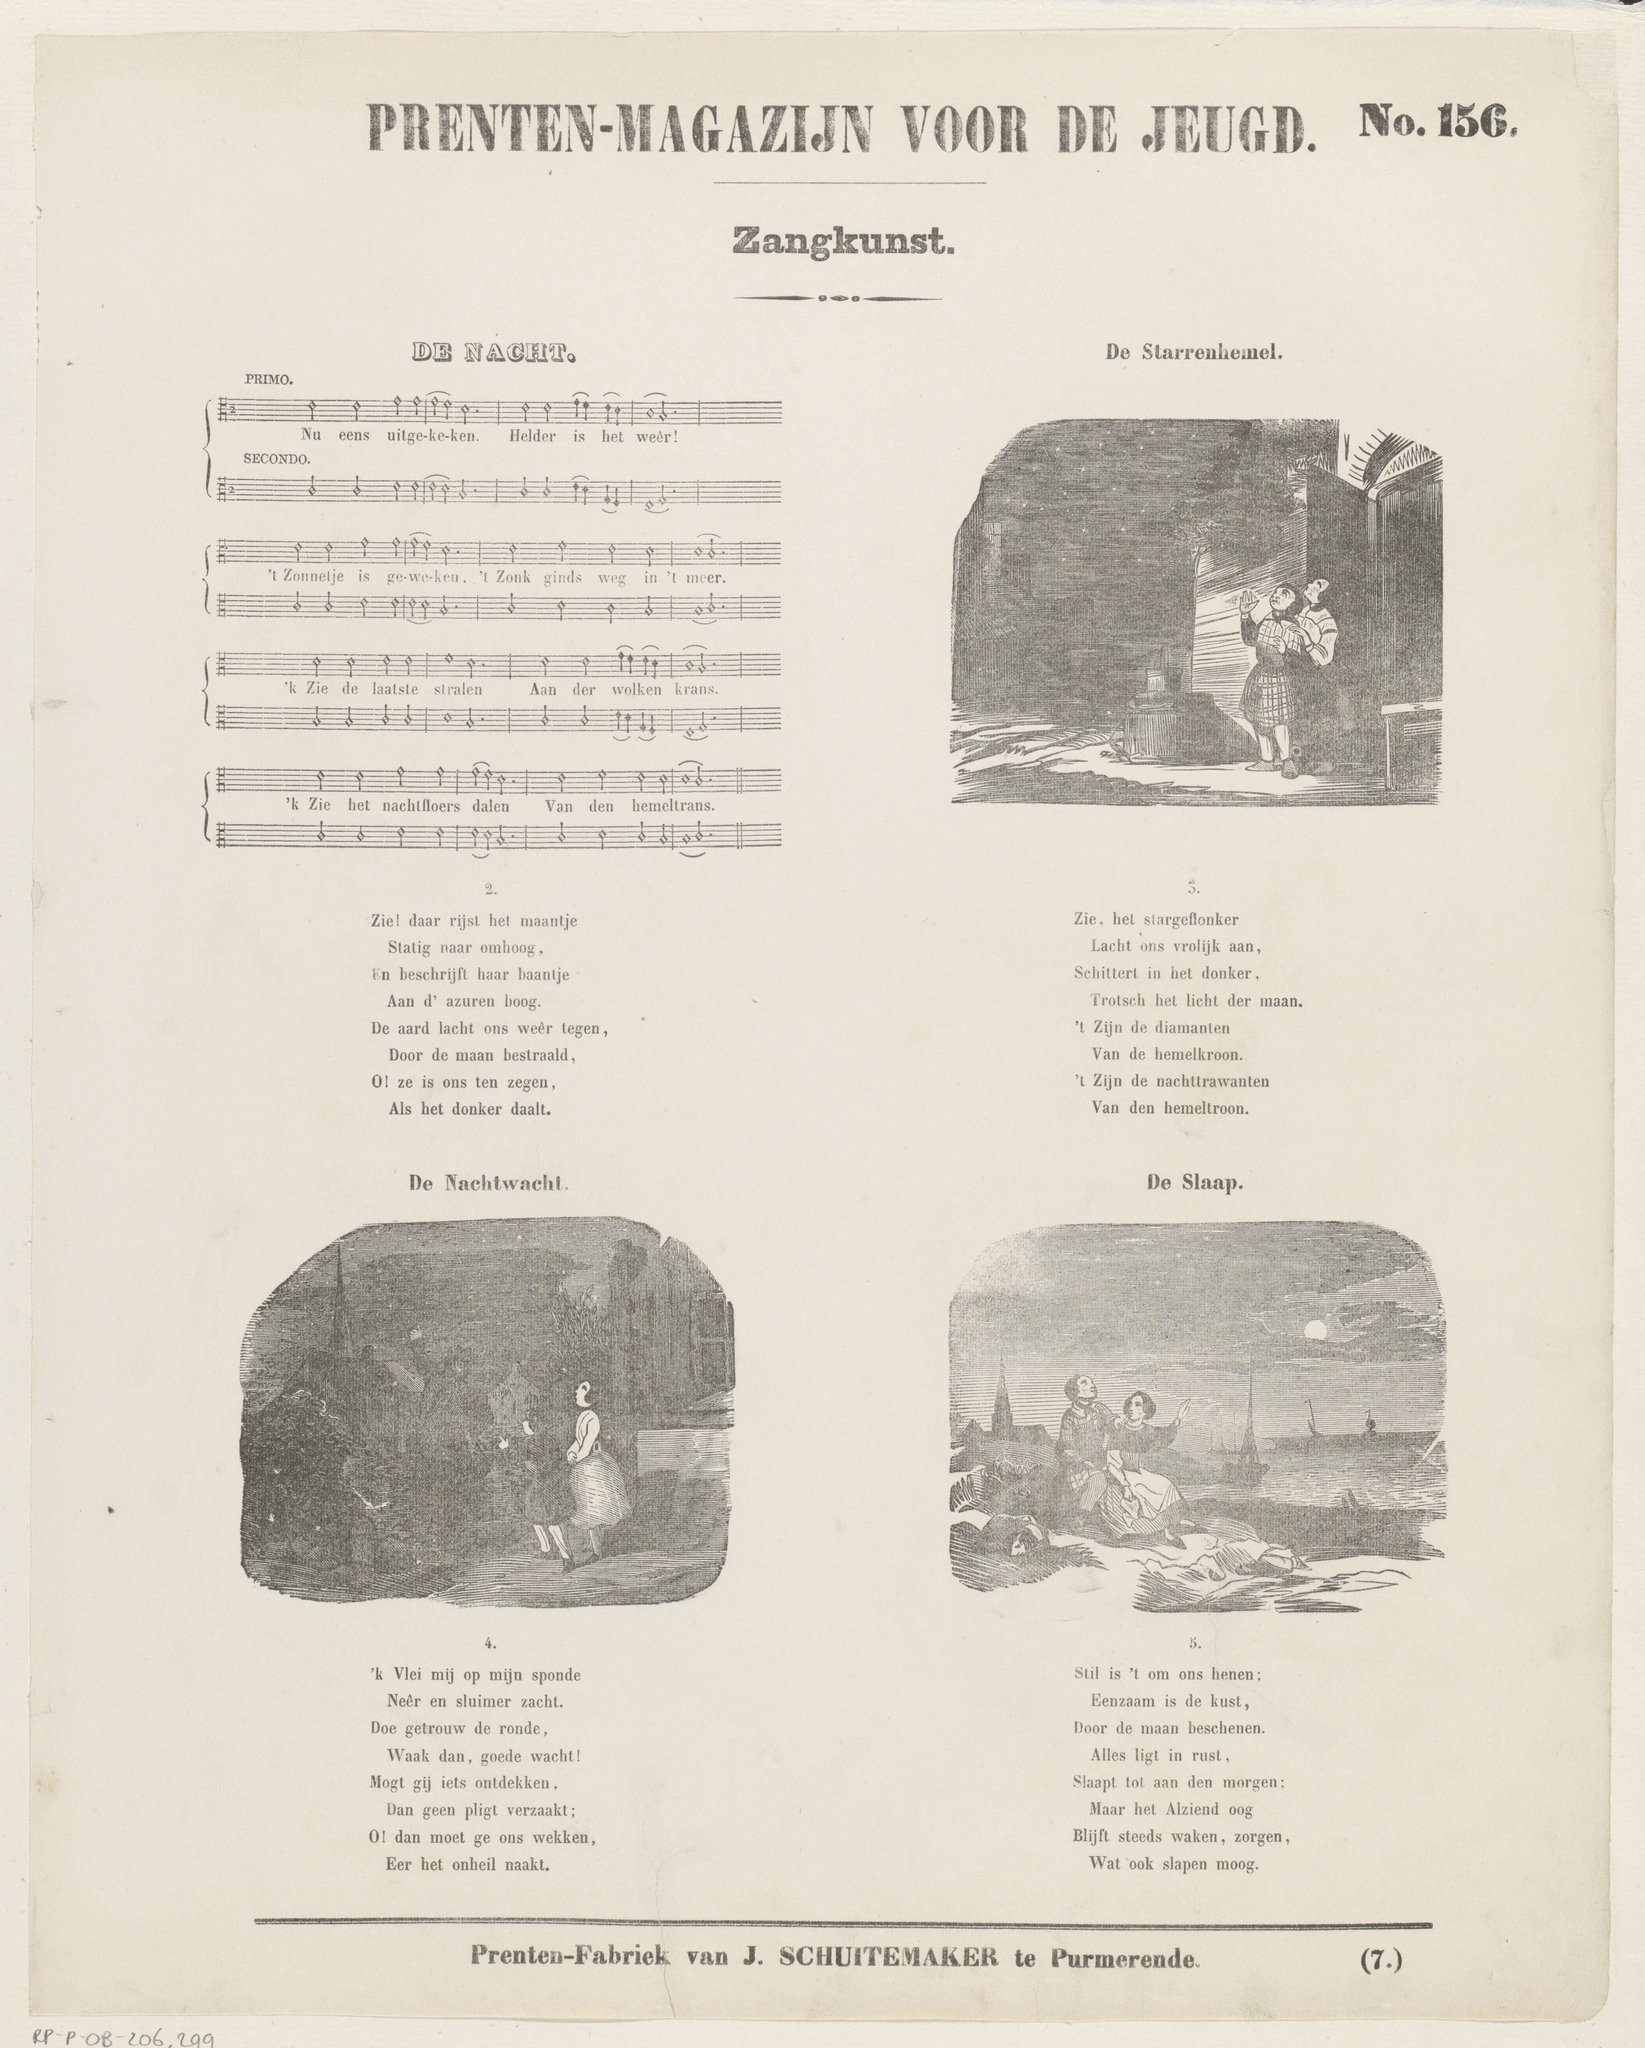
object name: print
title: Zangkunst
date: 1850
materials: paper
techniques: letterpress printing, engraving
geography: netherlands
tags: stars, night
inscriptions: collector's mark: Lugt 2760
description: Na voltooiing van de acht jaargangen van de reeks 'Prenten-magazijn voor de jeugd' in 1850 heeft Jan Schuitemaker al deze prenten heruitgegeven en omgenummerd als nr. 1 t/m 192. De oorspronkelijke jaargang wordt telkens nog vermeld rechtsonder op de prent. Binnen de jaargangen zijn prenten van hetzelfde thema in clusters van vier achter elkaar gezet.